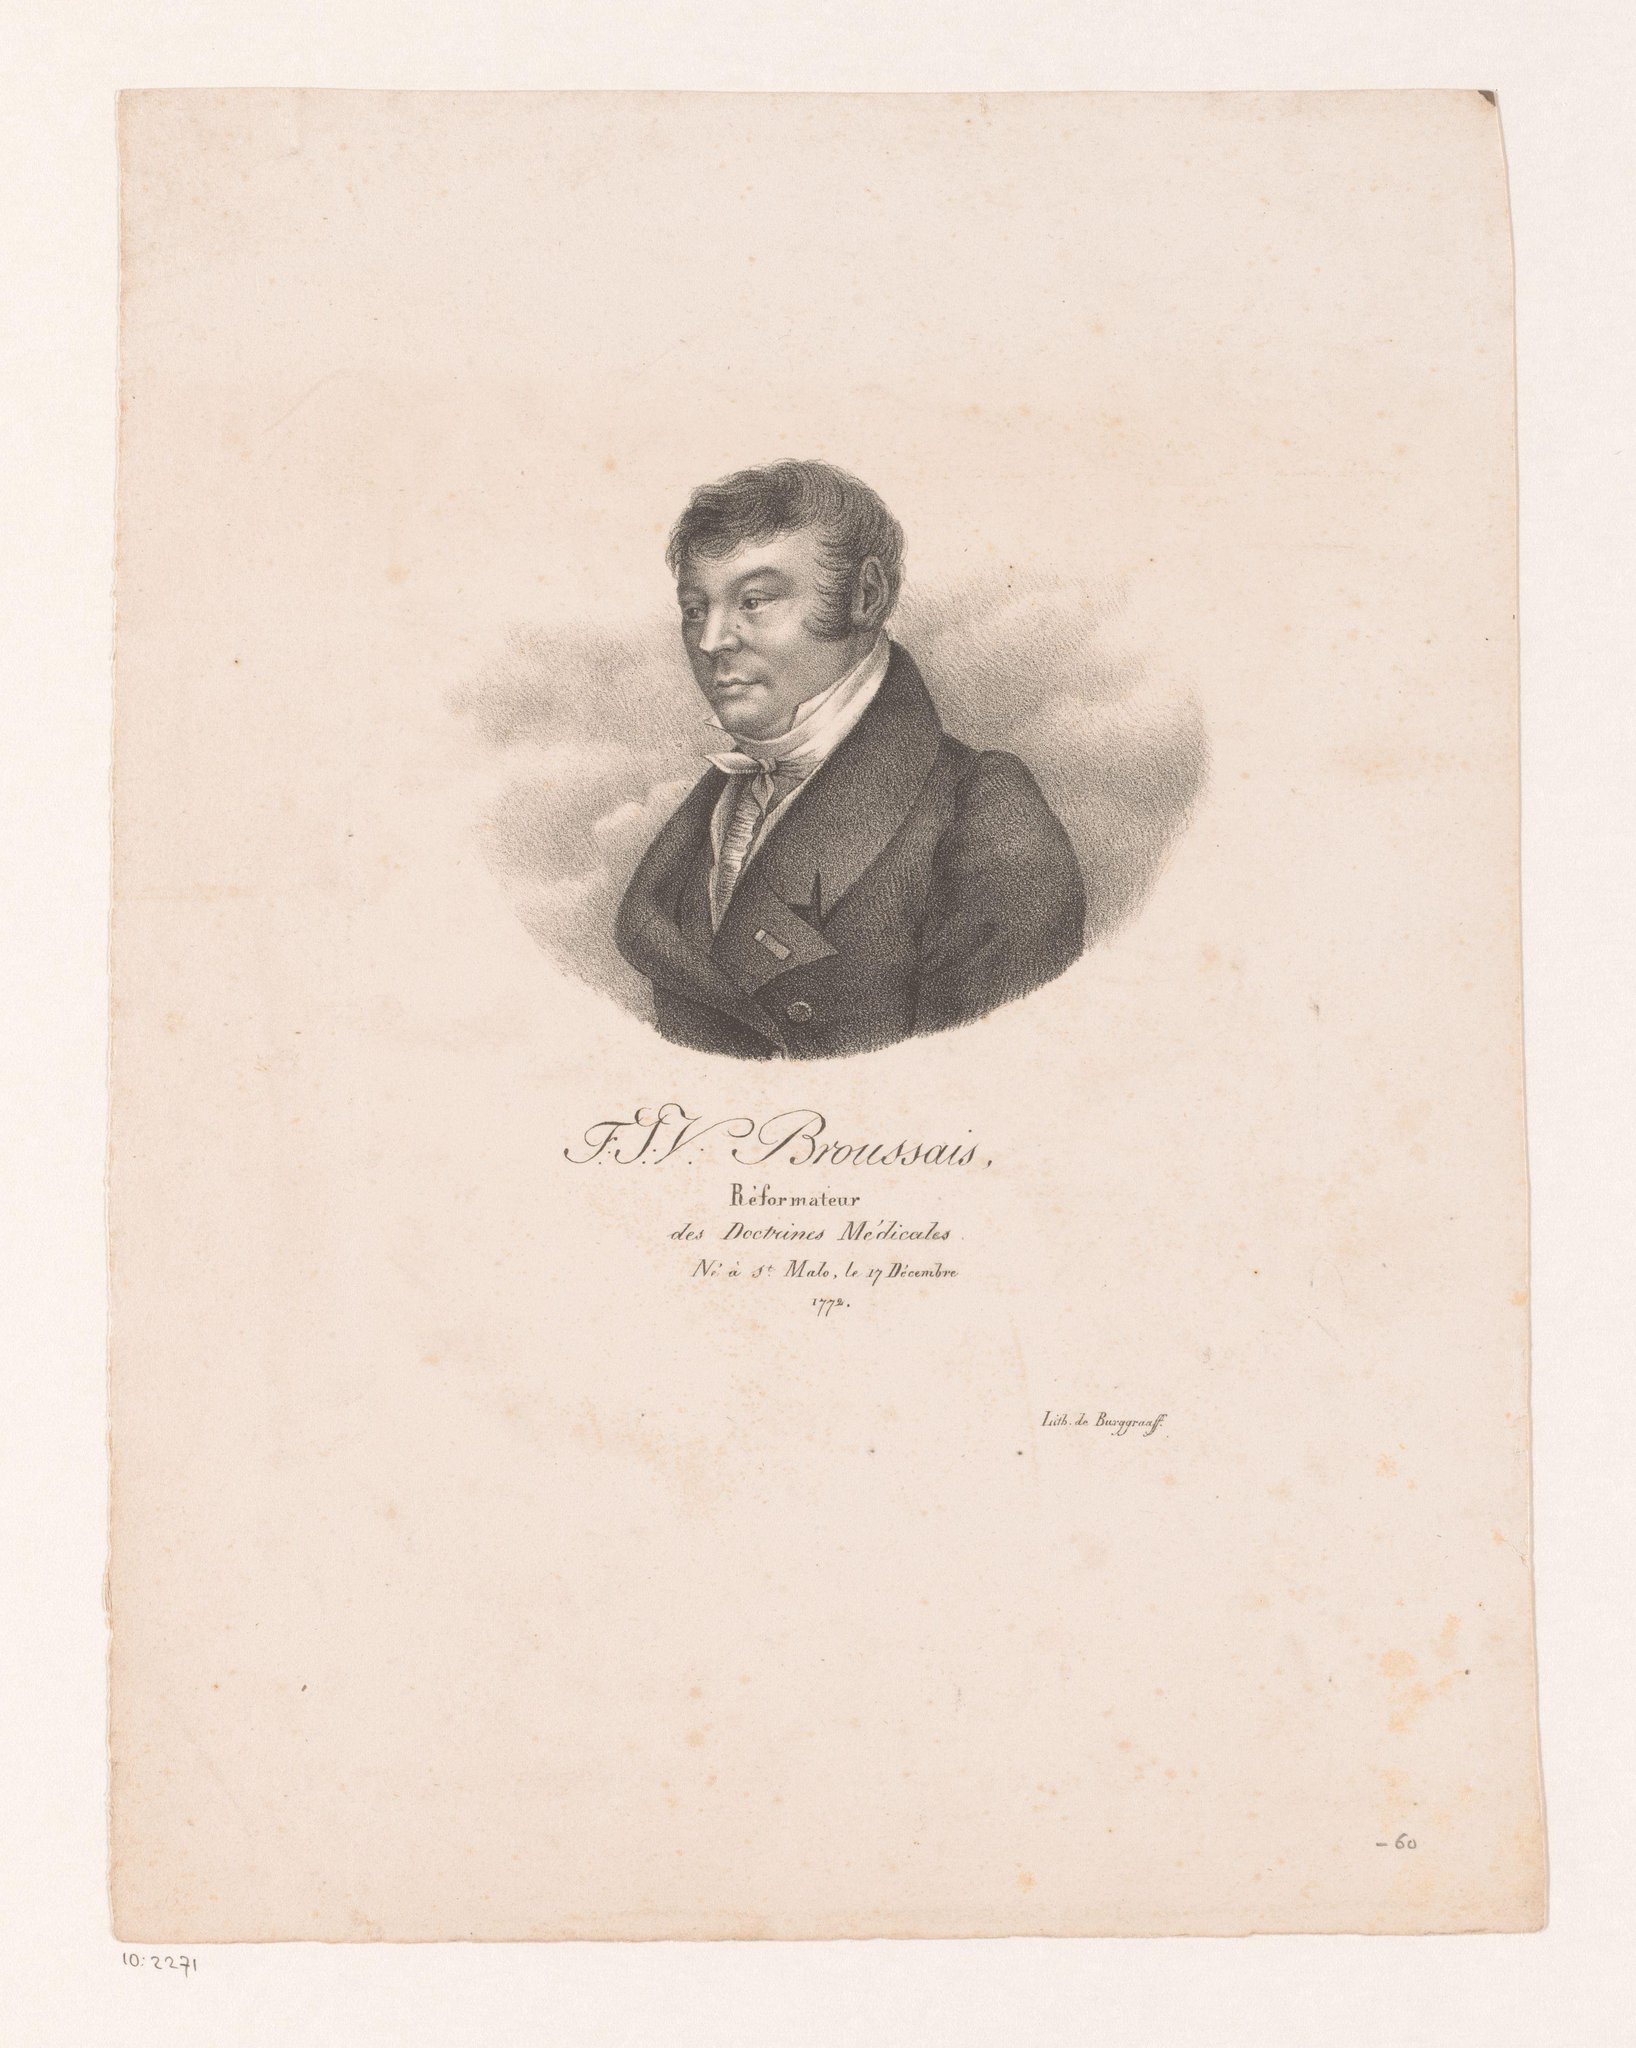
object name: print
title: Portret van François Broussais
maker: guillaume philidor van den burggraaff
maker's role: draughtsman, printer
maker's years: 1790-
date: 1800-1899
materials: paper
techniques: lithograph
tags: adult man, historical persons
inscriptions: collector's mark: Lugt 2228